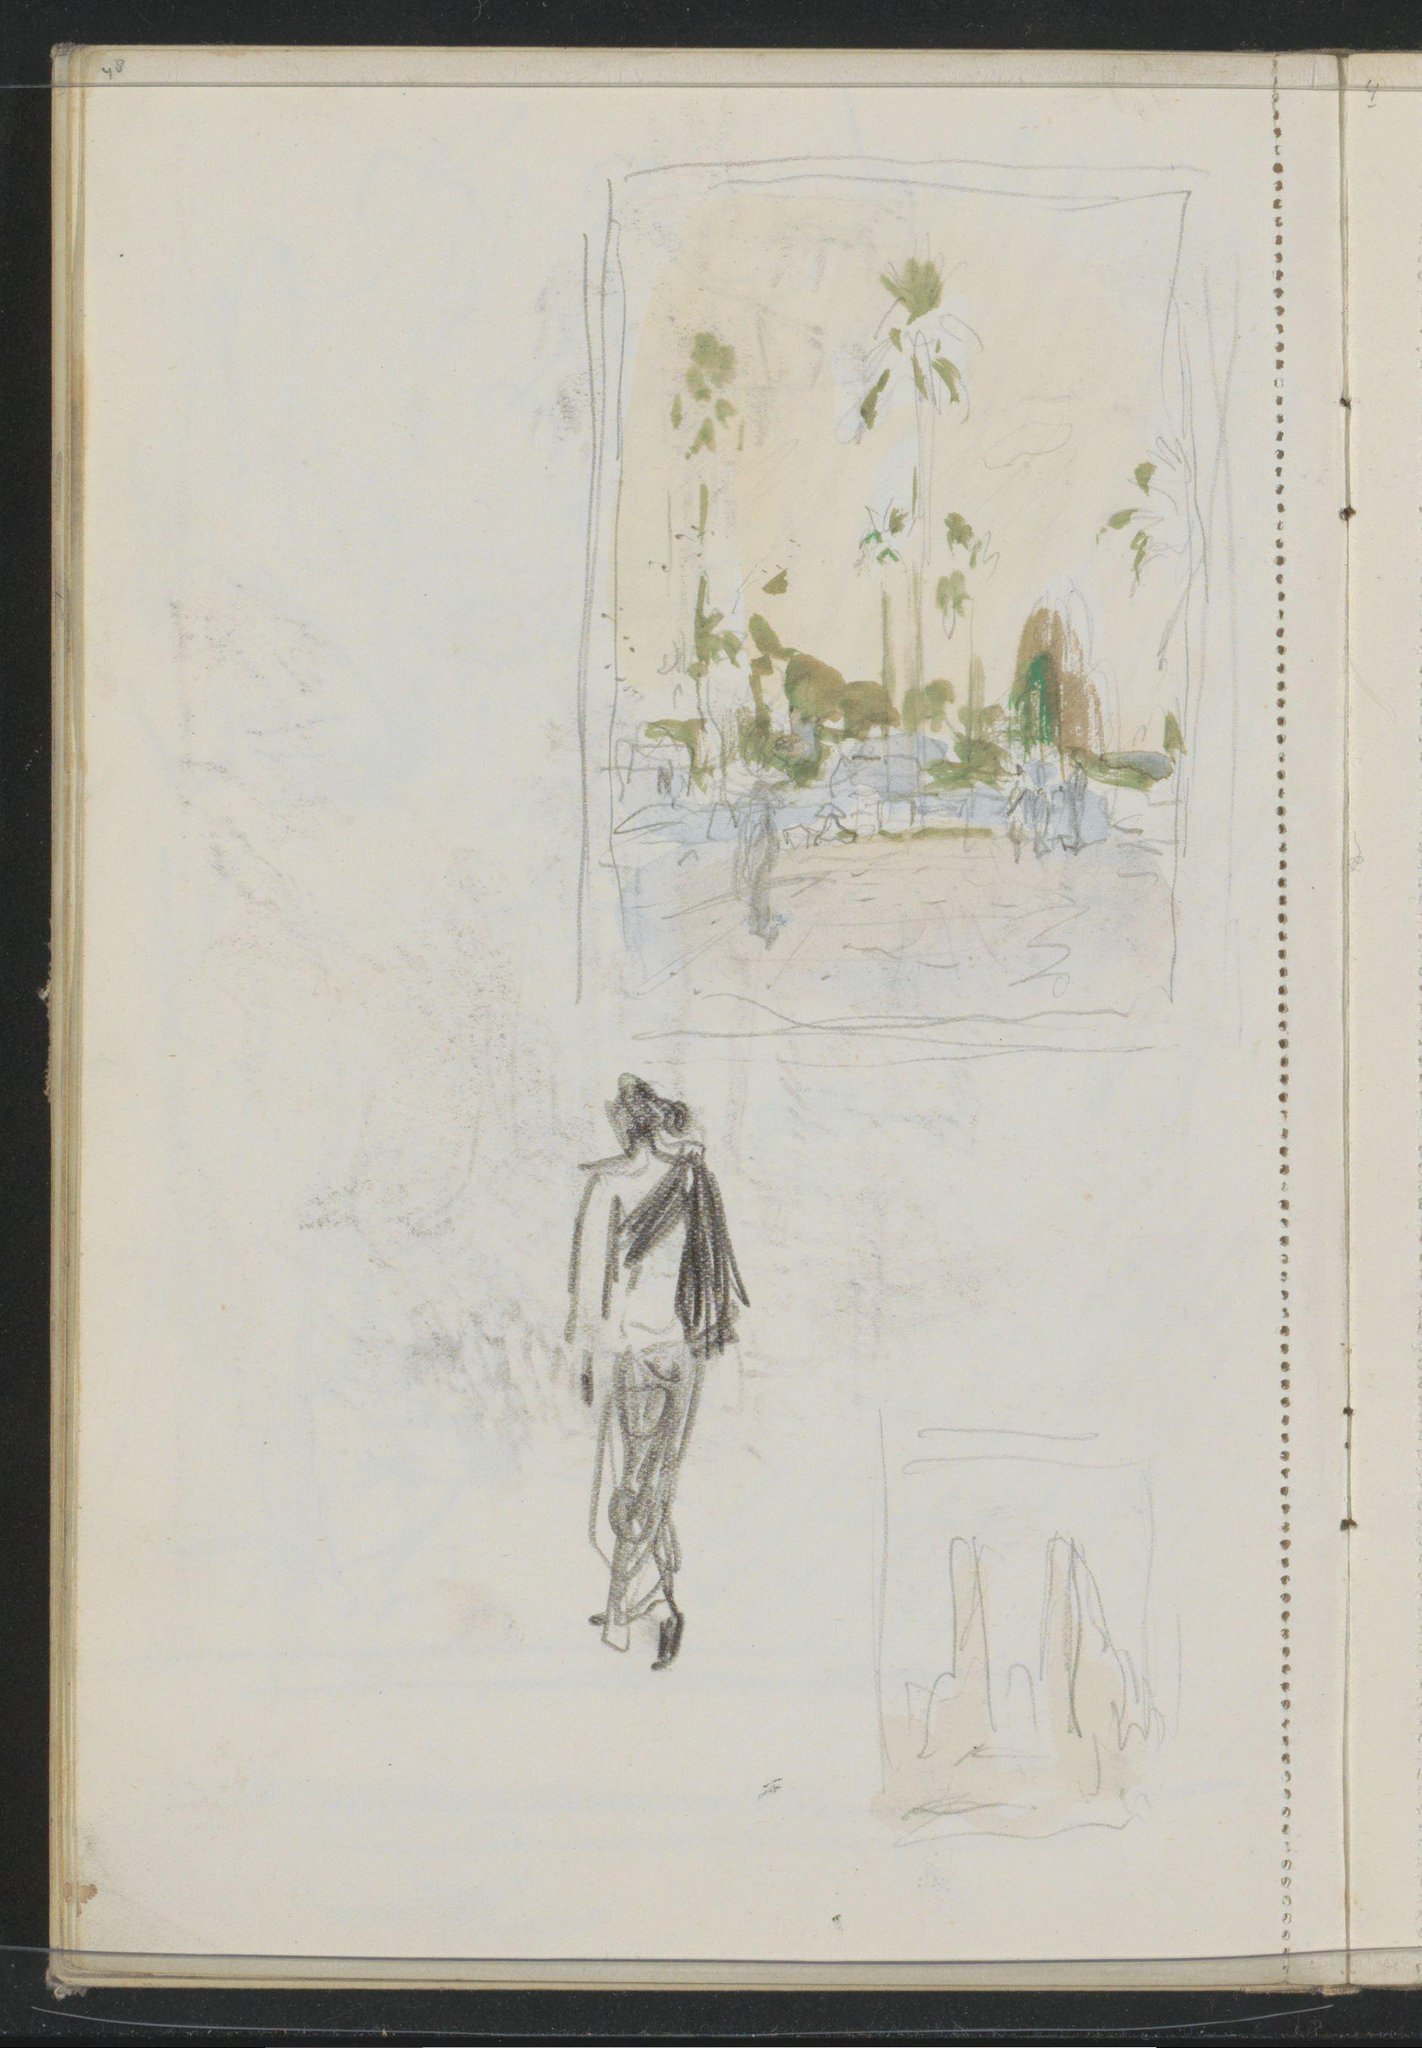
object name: sketchbook leaf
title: Landschap met figuren en palmbomen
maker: marius bauer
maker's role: draughtsman, print maker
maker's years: 1867-1932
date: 1925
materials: chalk, paper, pencil, watercolor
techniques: brush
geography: indonesia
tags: asiatic races and peoples, folk costume, regional costume, trees: palm-tree, landscapes (+ landscape with figures, staffage)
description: Tevens een studie van een Indonesiër in traditioneel kostuum, op de rug gezien. Pagina 48 uit een schetsboek met 74 bladen.